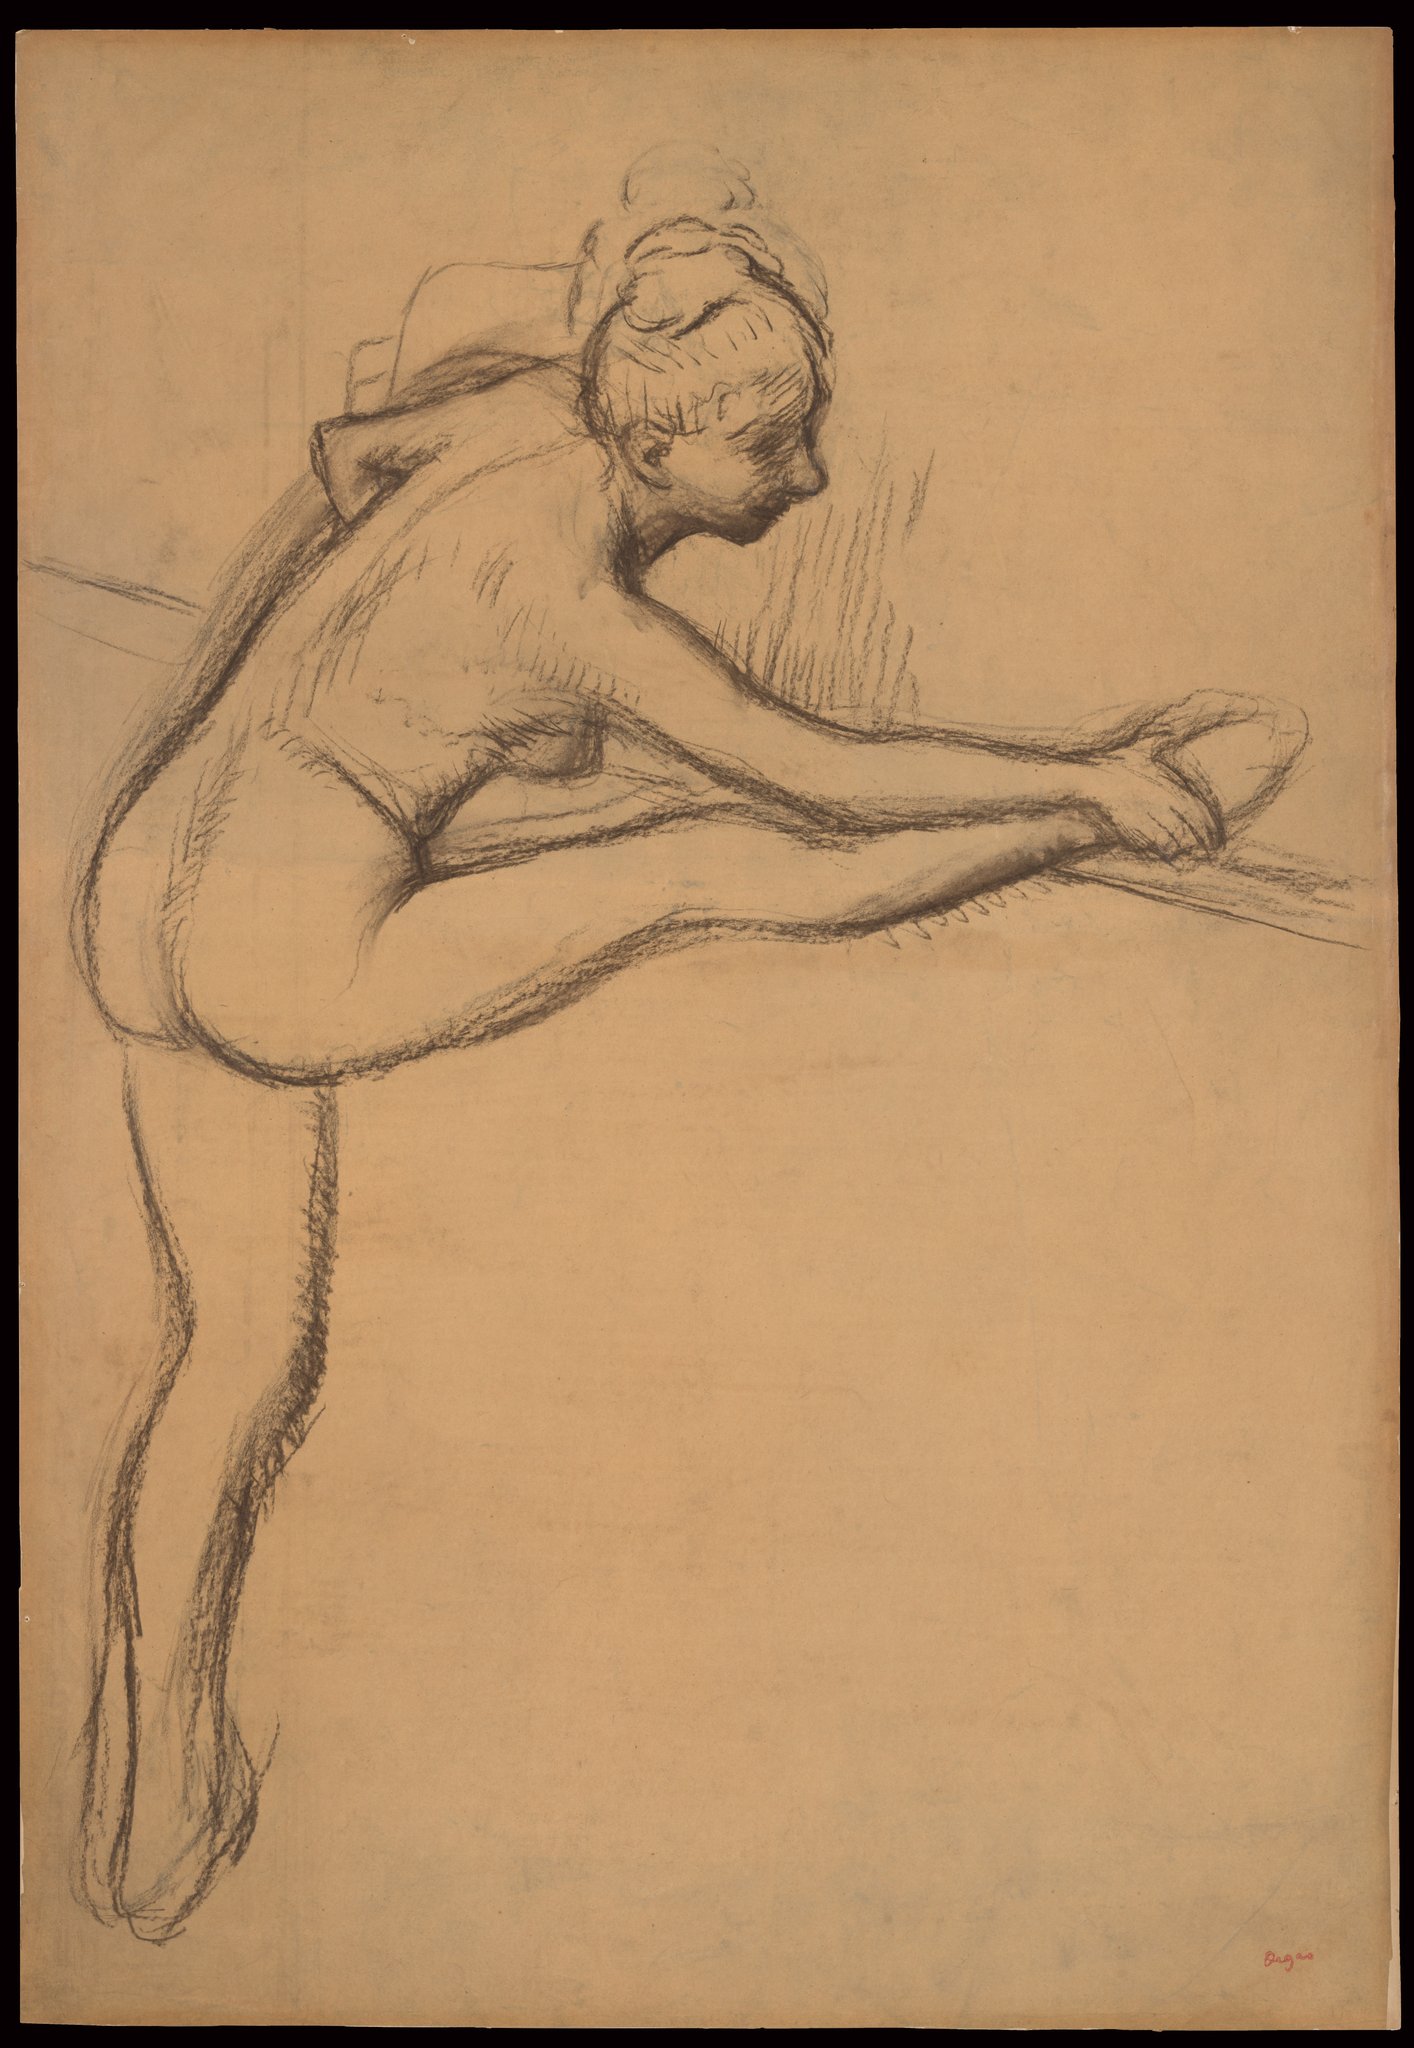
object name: drawing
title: Study of a Nude (Dancer at the Barre)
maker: edgar degas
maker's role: artist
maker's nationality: french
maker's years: 1834-1917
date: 1884-1900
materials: charcoal, paper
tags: female nudes,dancers